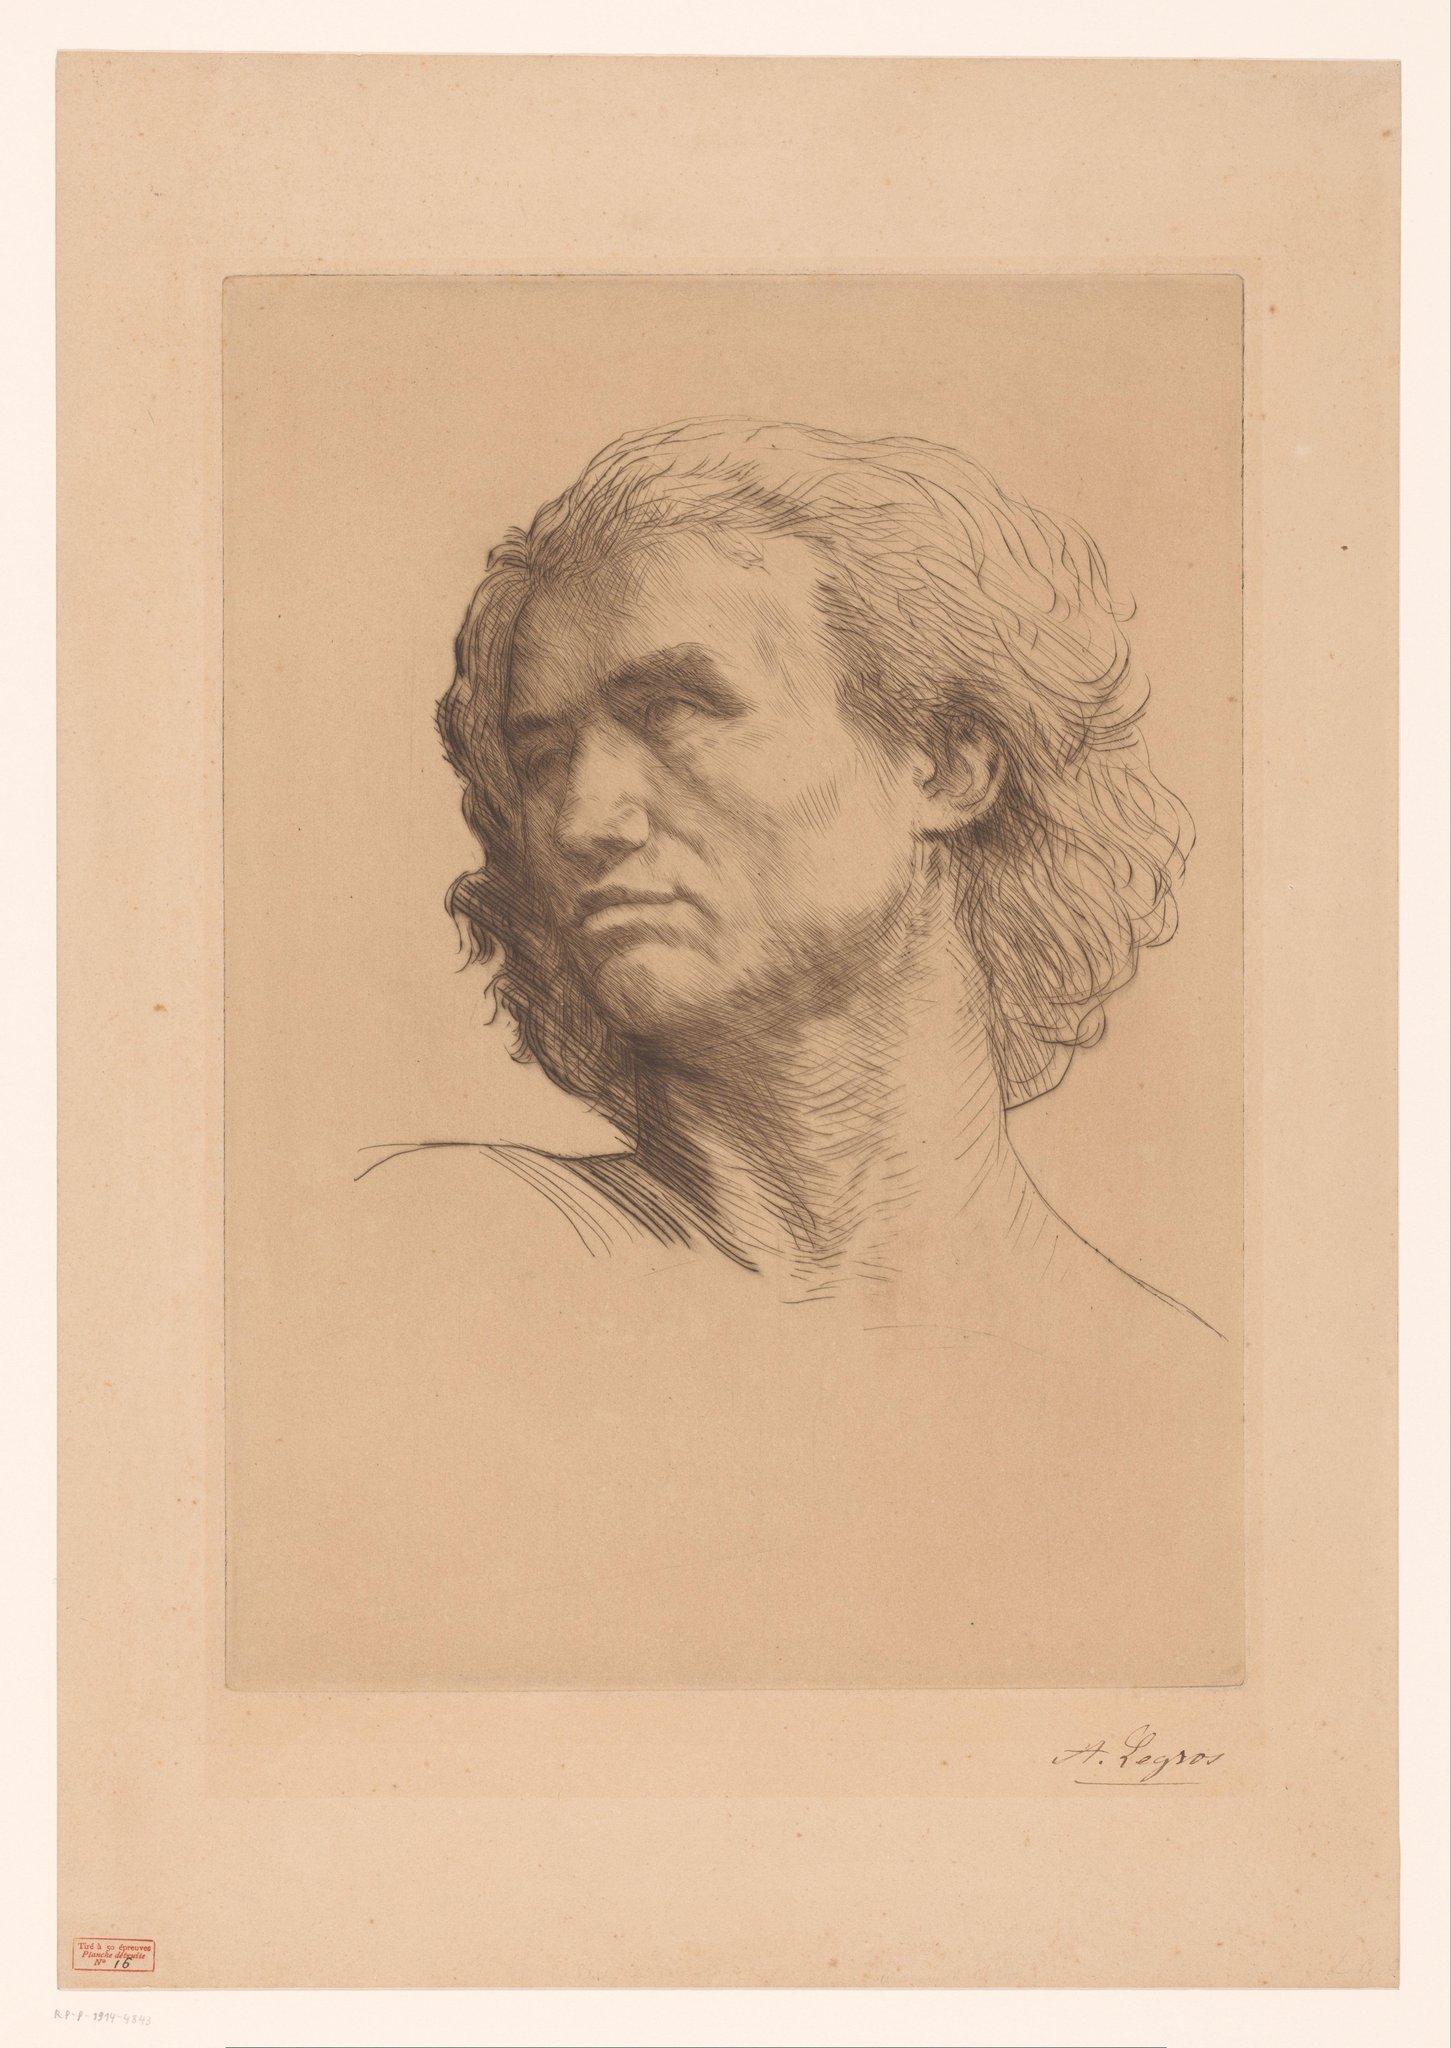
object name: print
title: Hoofd van een man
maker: alphonse legros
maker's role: print maker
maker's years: 1837-1911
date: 1847-1911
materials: paper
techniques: drypoint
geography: france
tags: adult man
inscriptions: collector's mark: Lugt 2228, stamp: ‘Tiré à 50 éprueves Plance détruite No 16’